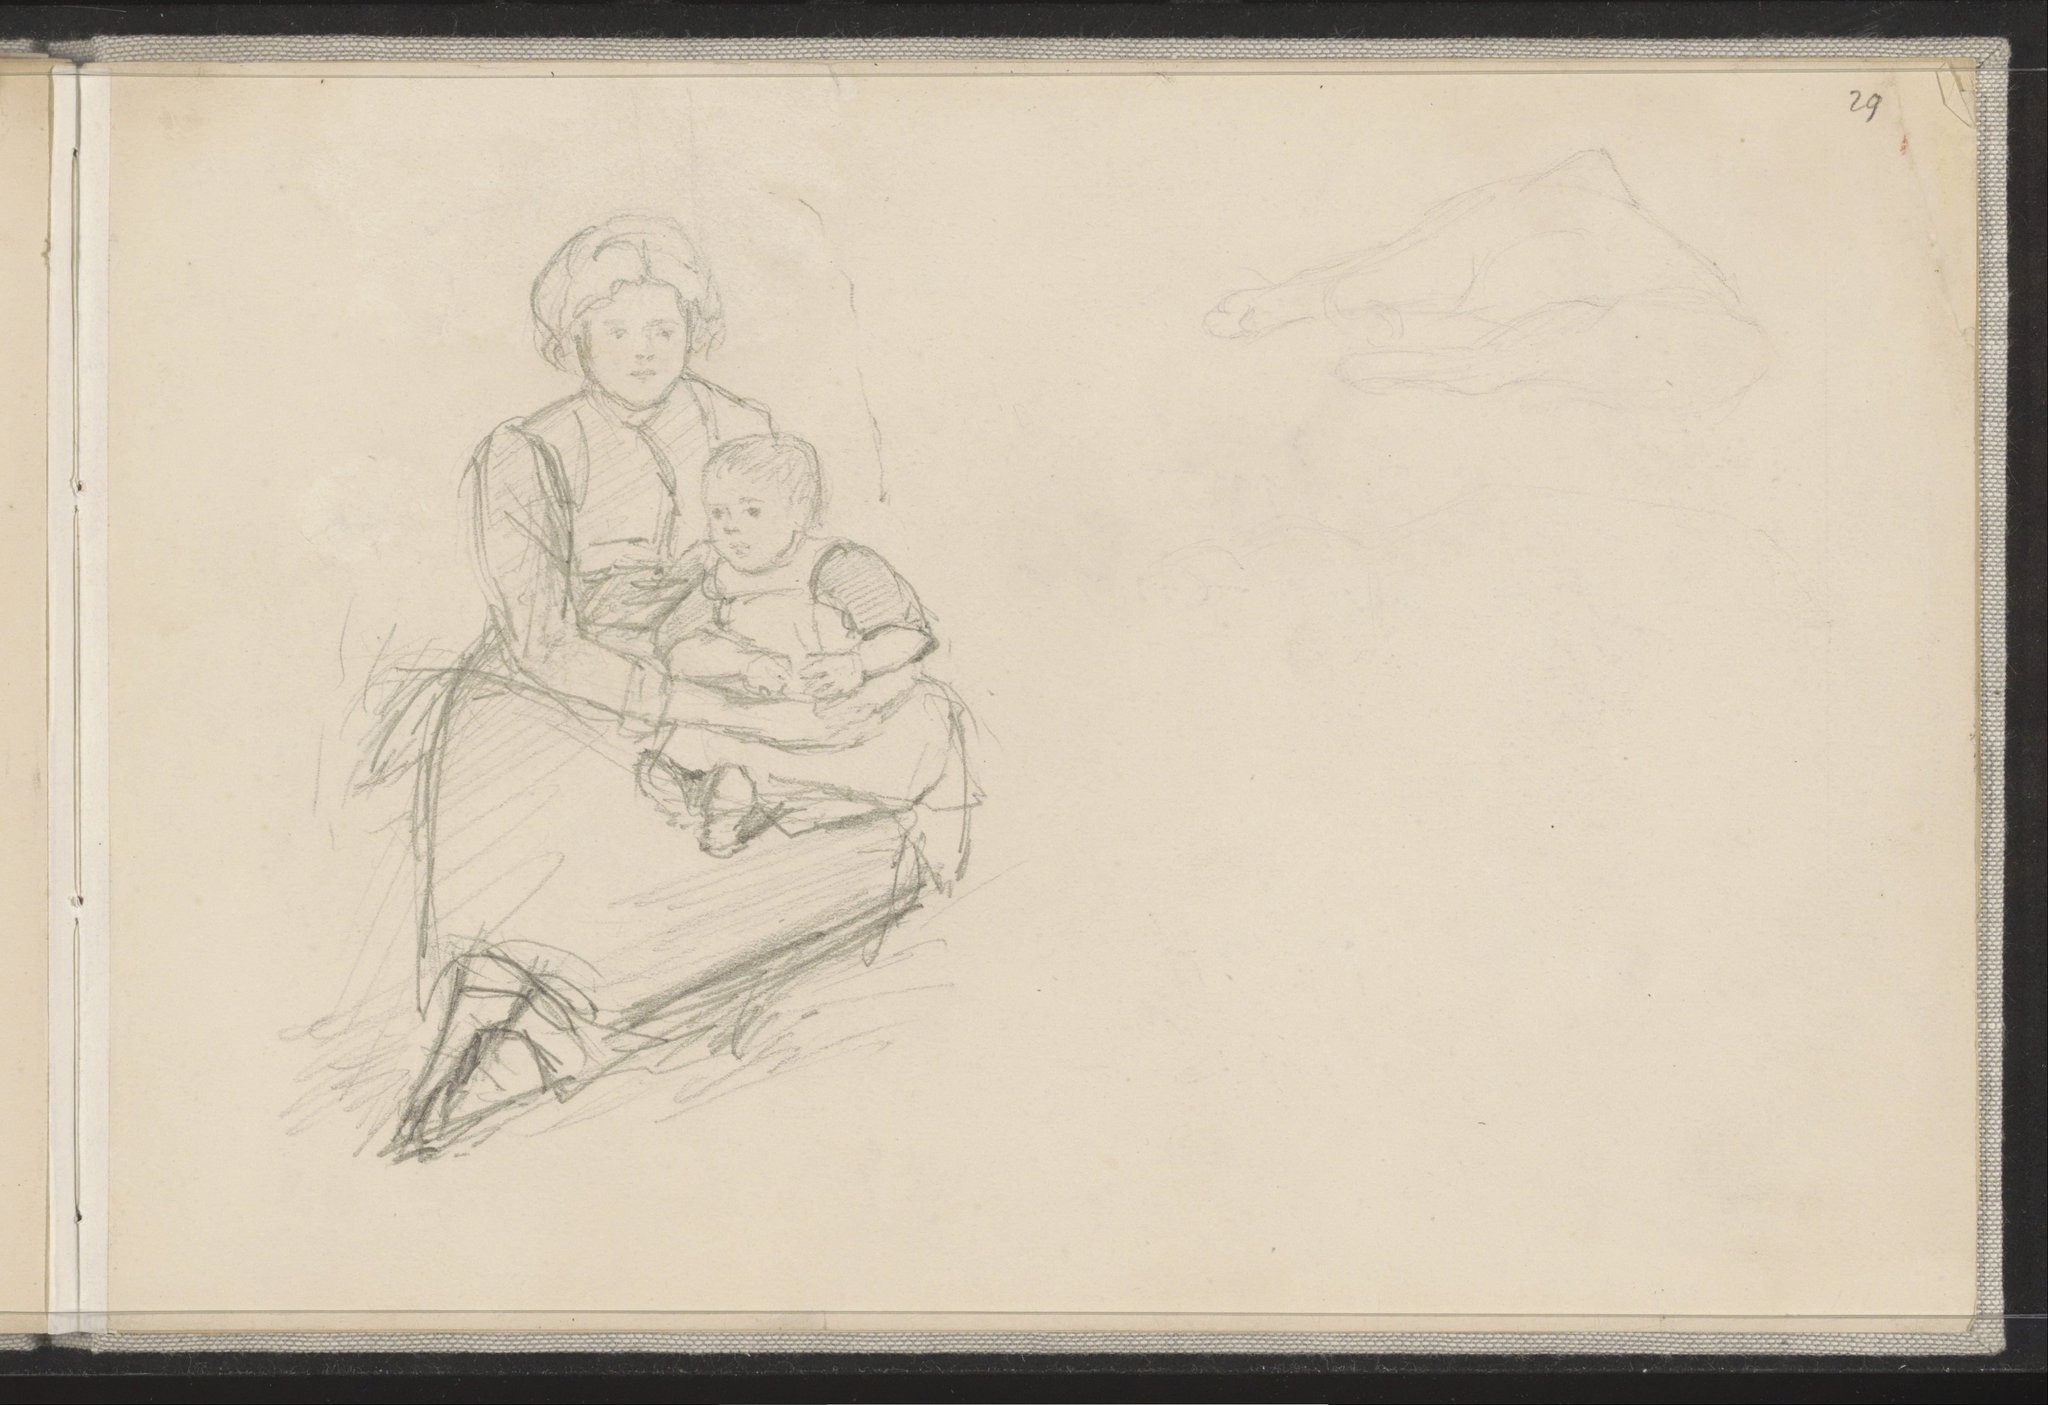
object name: sketchbook leaf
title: Moeder met een baby op schoot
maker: jozef israëls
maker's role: draughtsman, painter, print maker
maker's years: 1824-1911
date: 1834-1911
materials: paper, pencil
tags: mother and baby or young child, dog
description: Tevens een studie van een liggend dier, vermoedelijk een hond. Blad 29 recto uit een schetsboek met 30 bladen.